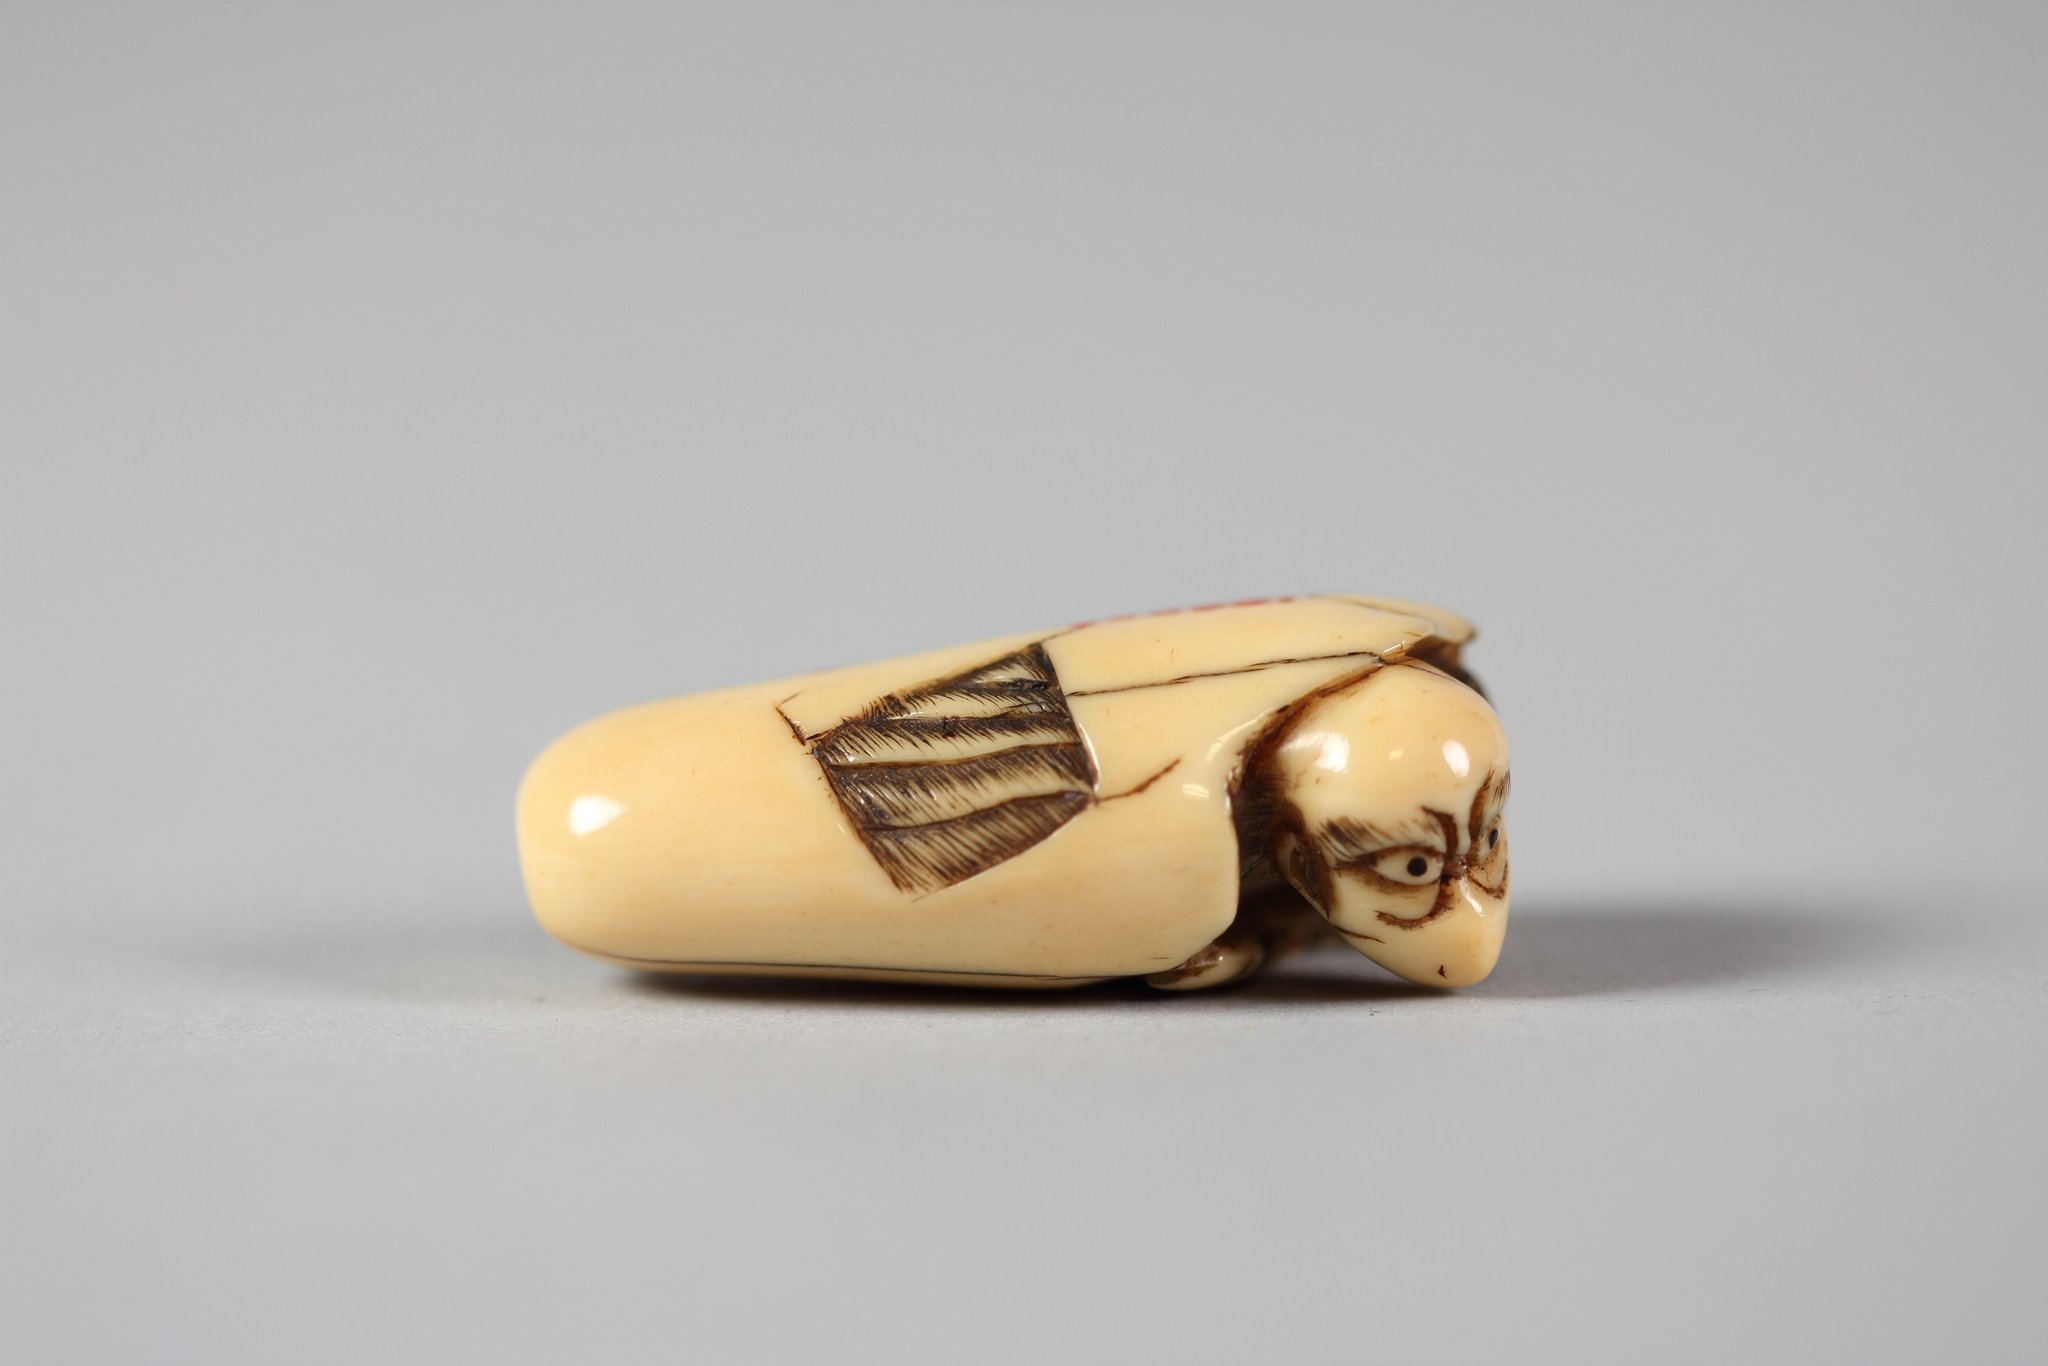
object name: netsuke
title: Netsuke of Monkey in a Bulb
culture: japanese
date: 1801-1900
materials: ivory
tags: monkeys